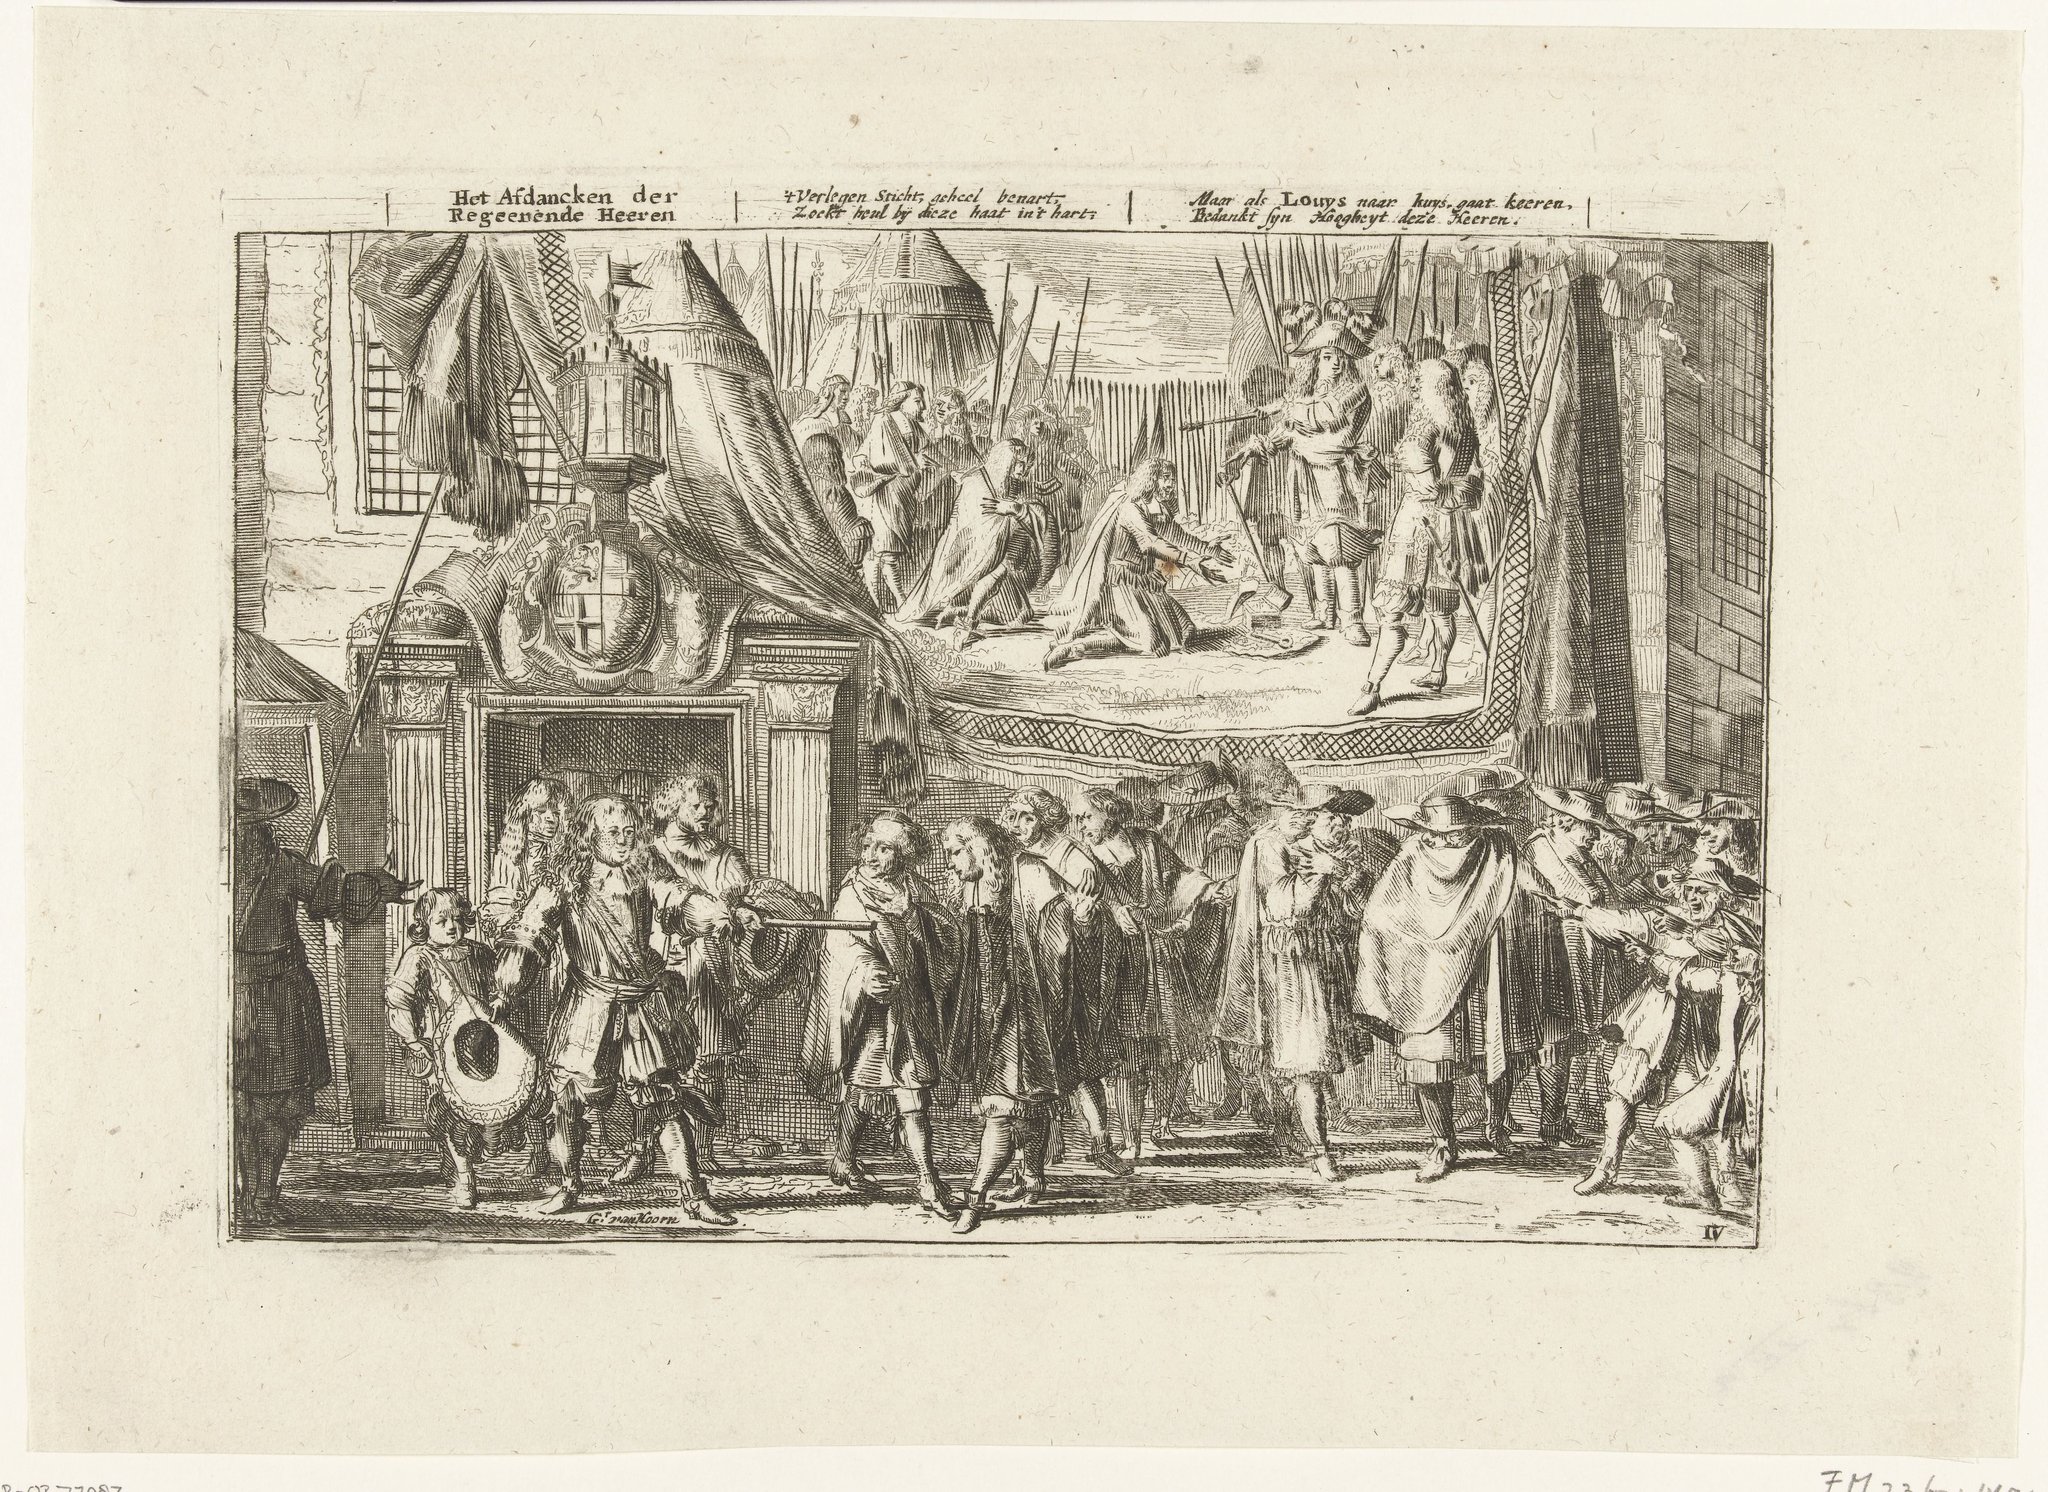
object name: print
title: Na het vertrek van de Fransen uit Utrecht worden de leden van de vroedschap de laan uit gestuurd, 1673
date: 1674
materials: paper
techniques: engraving, etching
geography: amsterdam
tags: involuntary abdication (of a ruler), utrecht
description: Na het vertrek van de Fransen uit Utrecht in 1673 stuurt Willem Adriaan, graaf van Hornes de leden van de vroedschap de laan uit. Boven deze voorstelling wordt in herinnering geroepen hoe het stadsbestuur de sleutels van de stad aan Lodewijk XIV had overhandigd. Bovenaan twee tweeregelige verzen in het Nederlands. Vierde prent in een reeks van vijf prenten over de gebeurtenissen voorgevallen in Utrecht over de periode 1672-74.